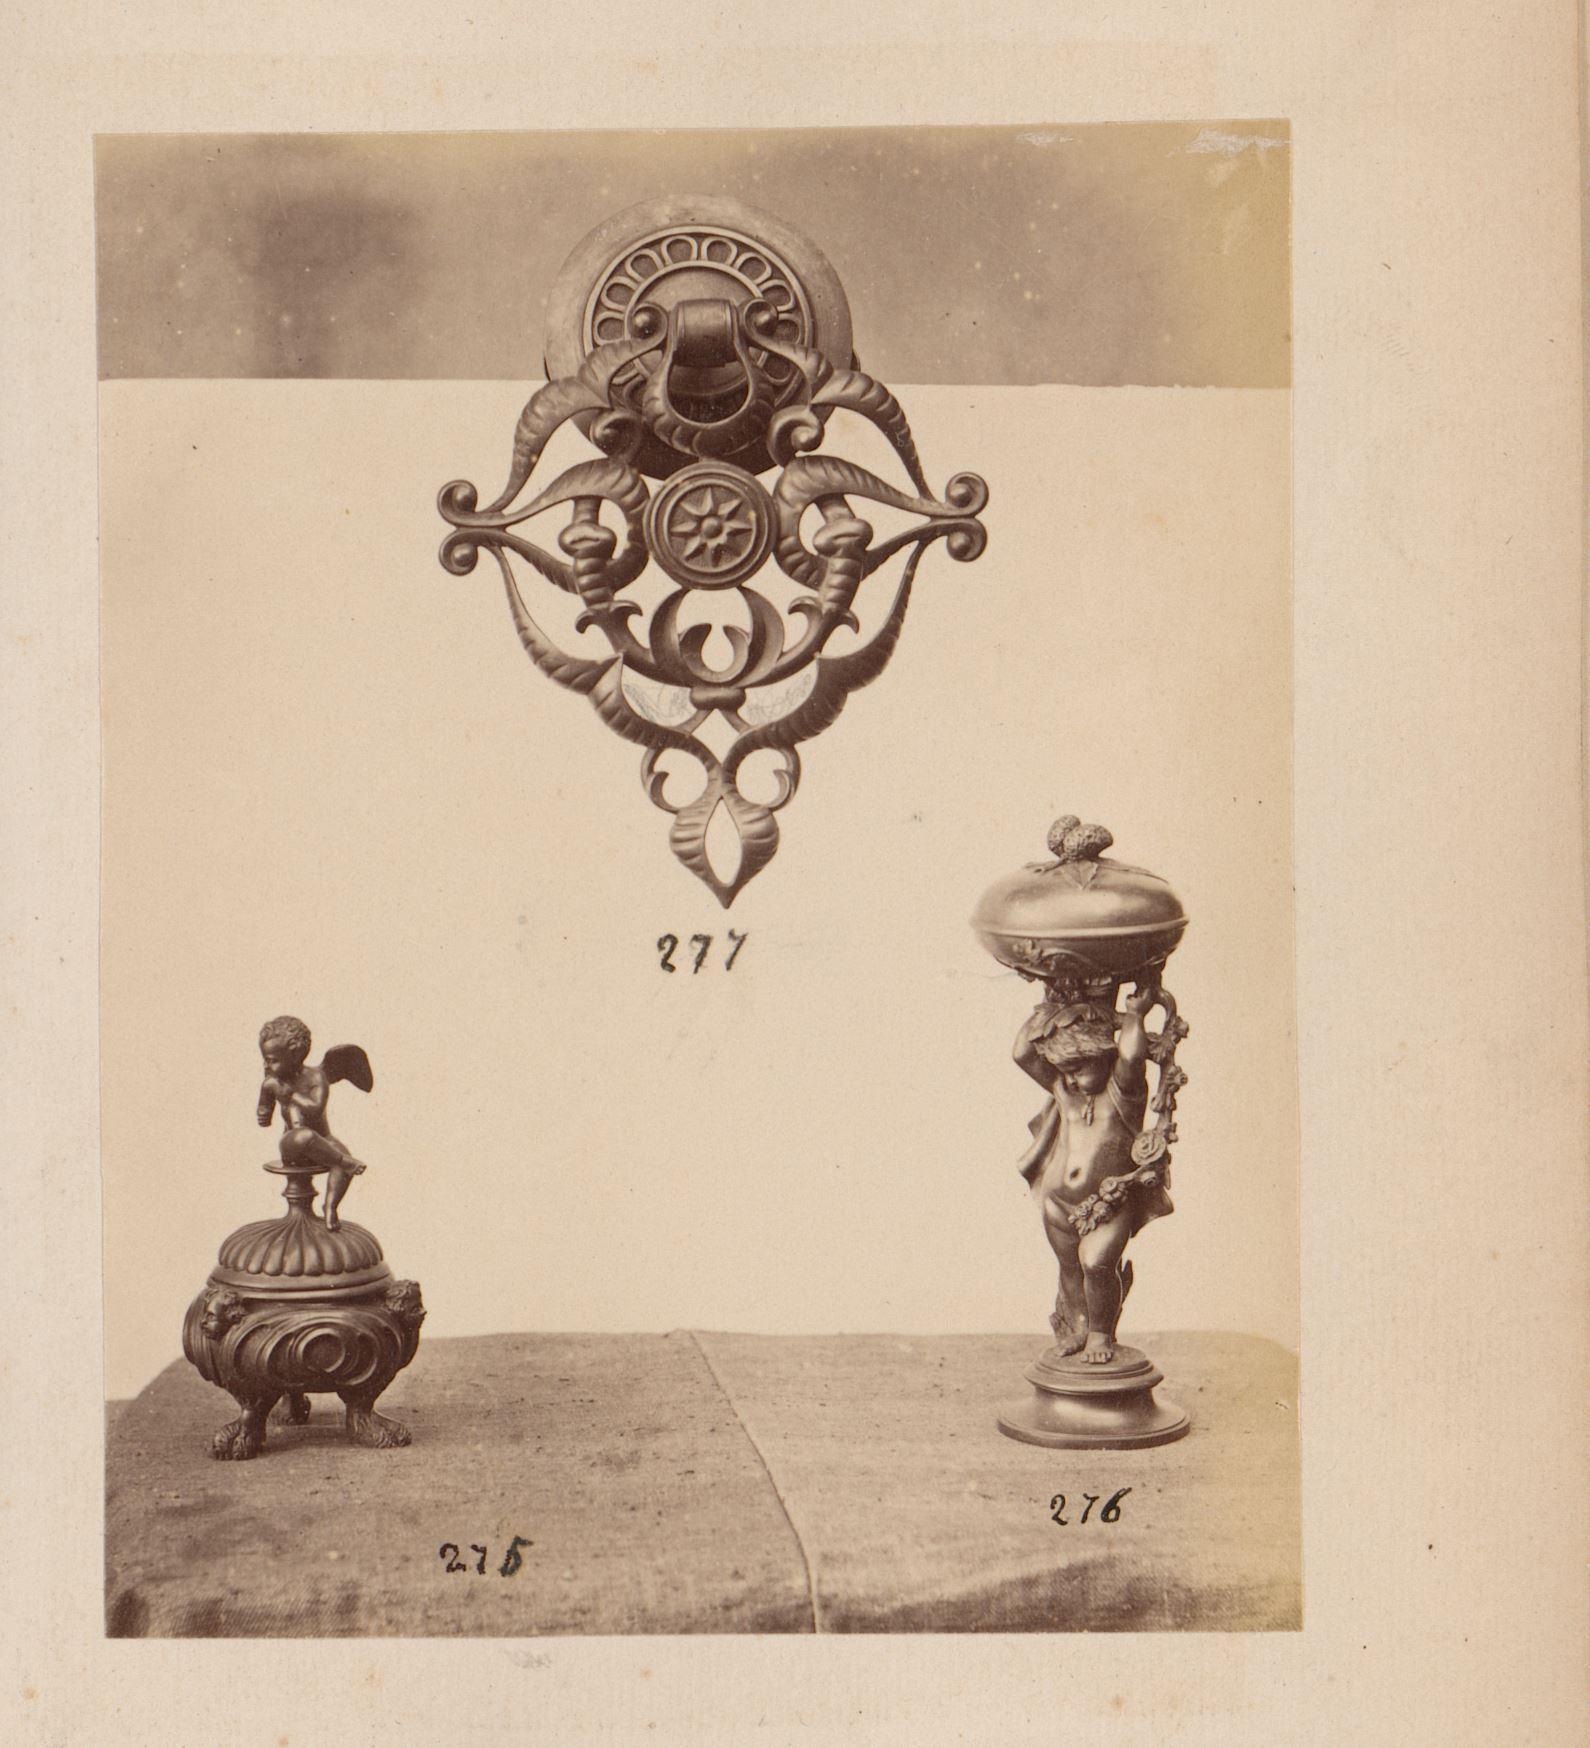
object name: photograph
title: Twee metalen vaten en een deurklopper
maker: Anonymous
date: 1860-1885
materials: photographic support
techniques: albumen print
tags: door-knocker, doorbell